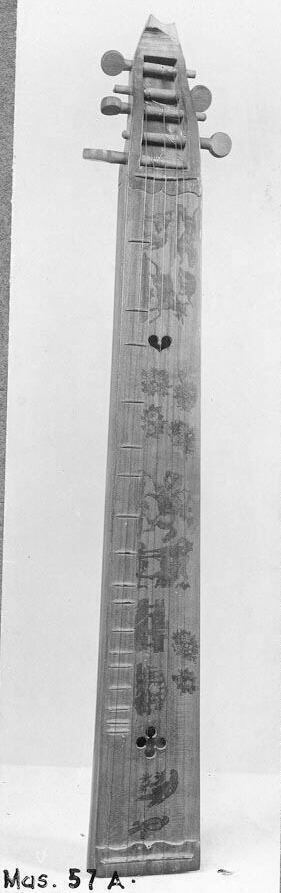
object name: épinette de vosges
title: Épinette des Vosges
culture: french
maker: amant constant (amé) lambert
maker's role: maker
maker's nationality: french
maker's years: 1843-1908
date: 1867-1900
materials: metal, wood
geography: france